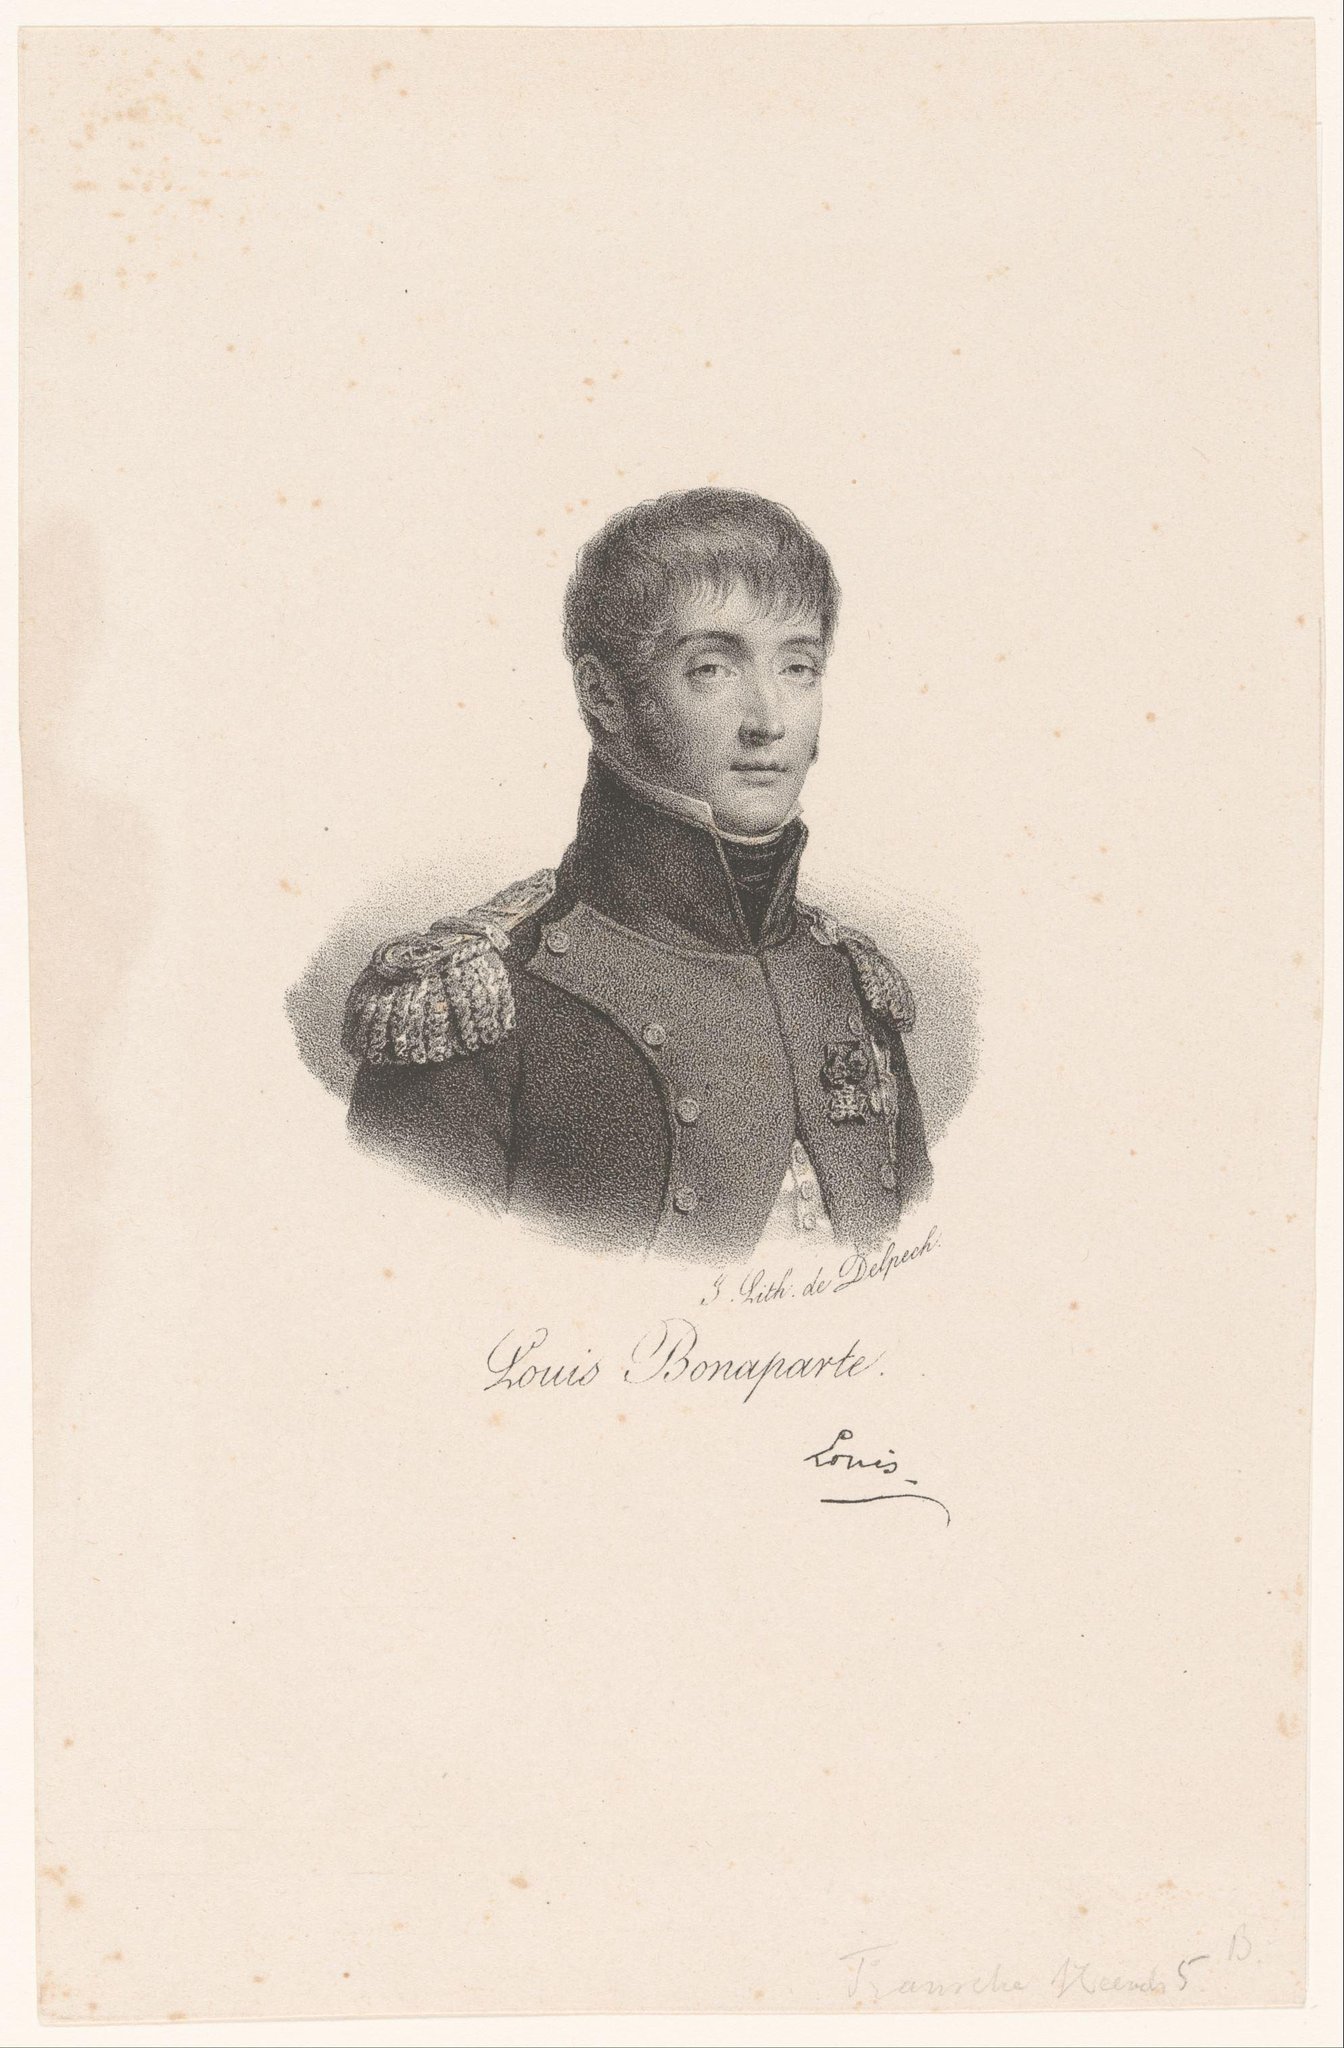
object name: print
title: Portret van Lodewijk Napoleon Bonaparte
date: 1818-1842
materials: paper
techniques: lithograph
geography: paris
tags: louis napoleon (king of holland), historical persons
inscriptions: collector's mark: Lugt 2228a